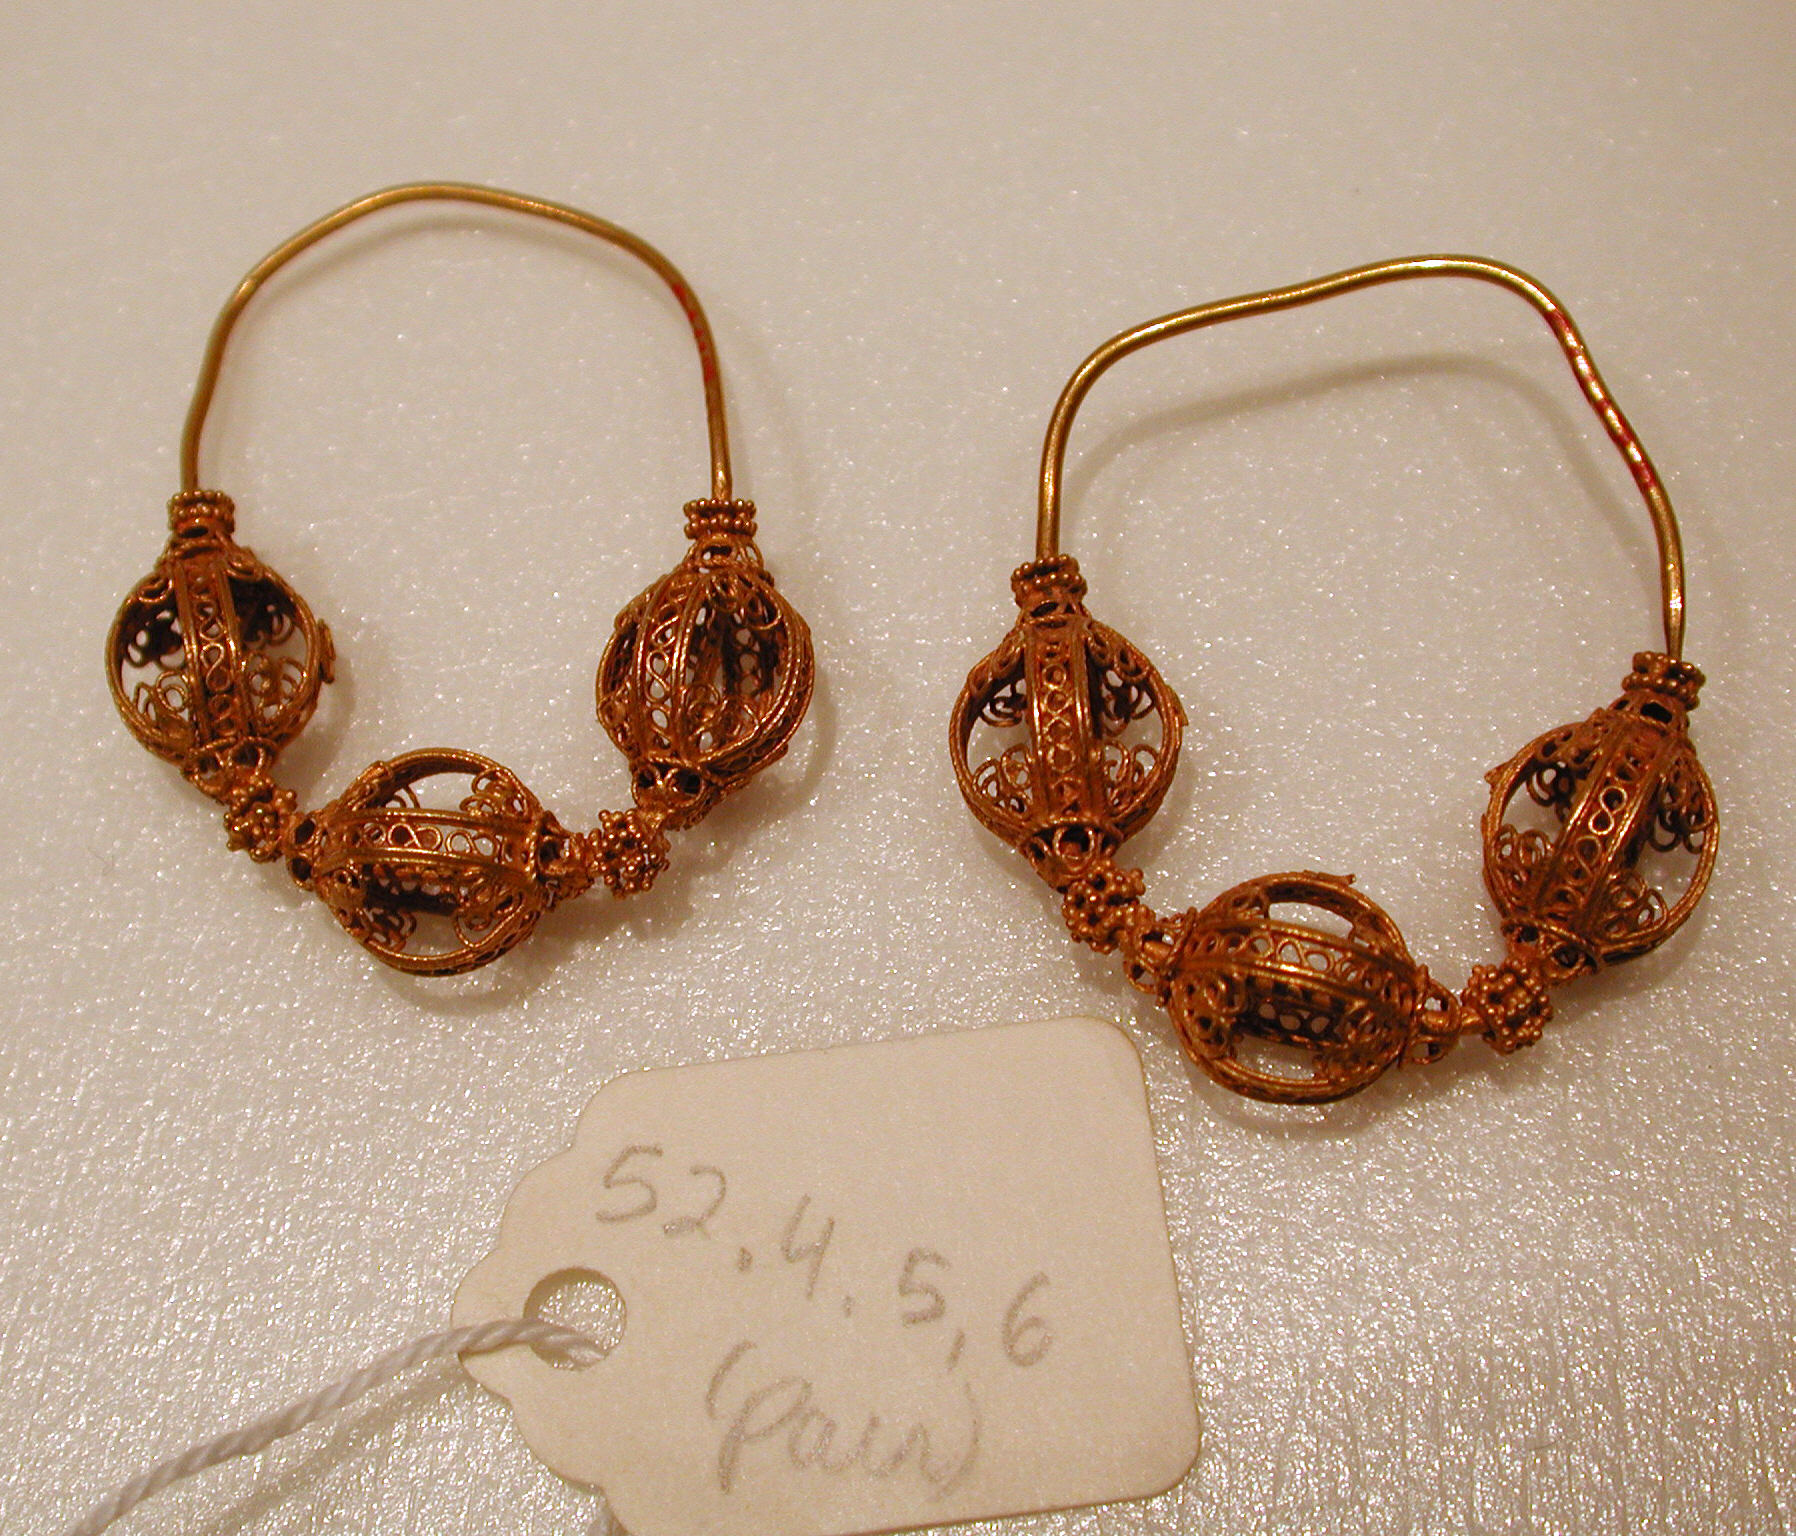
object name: earring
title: Earring, One of a Pair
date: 1101-1300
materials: gold, metal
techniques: filigree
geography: iran